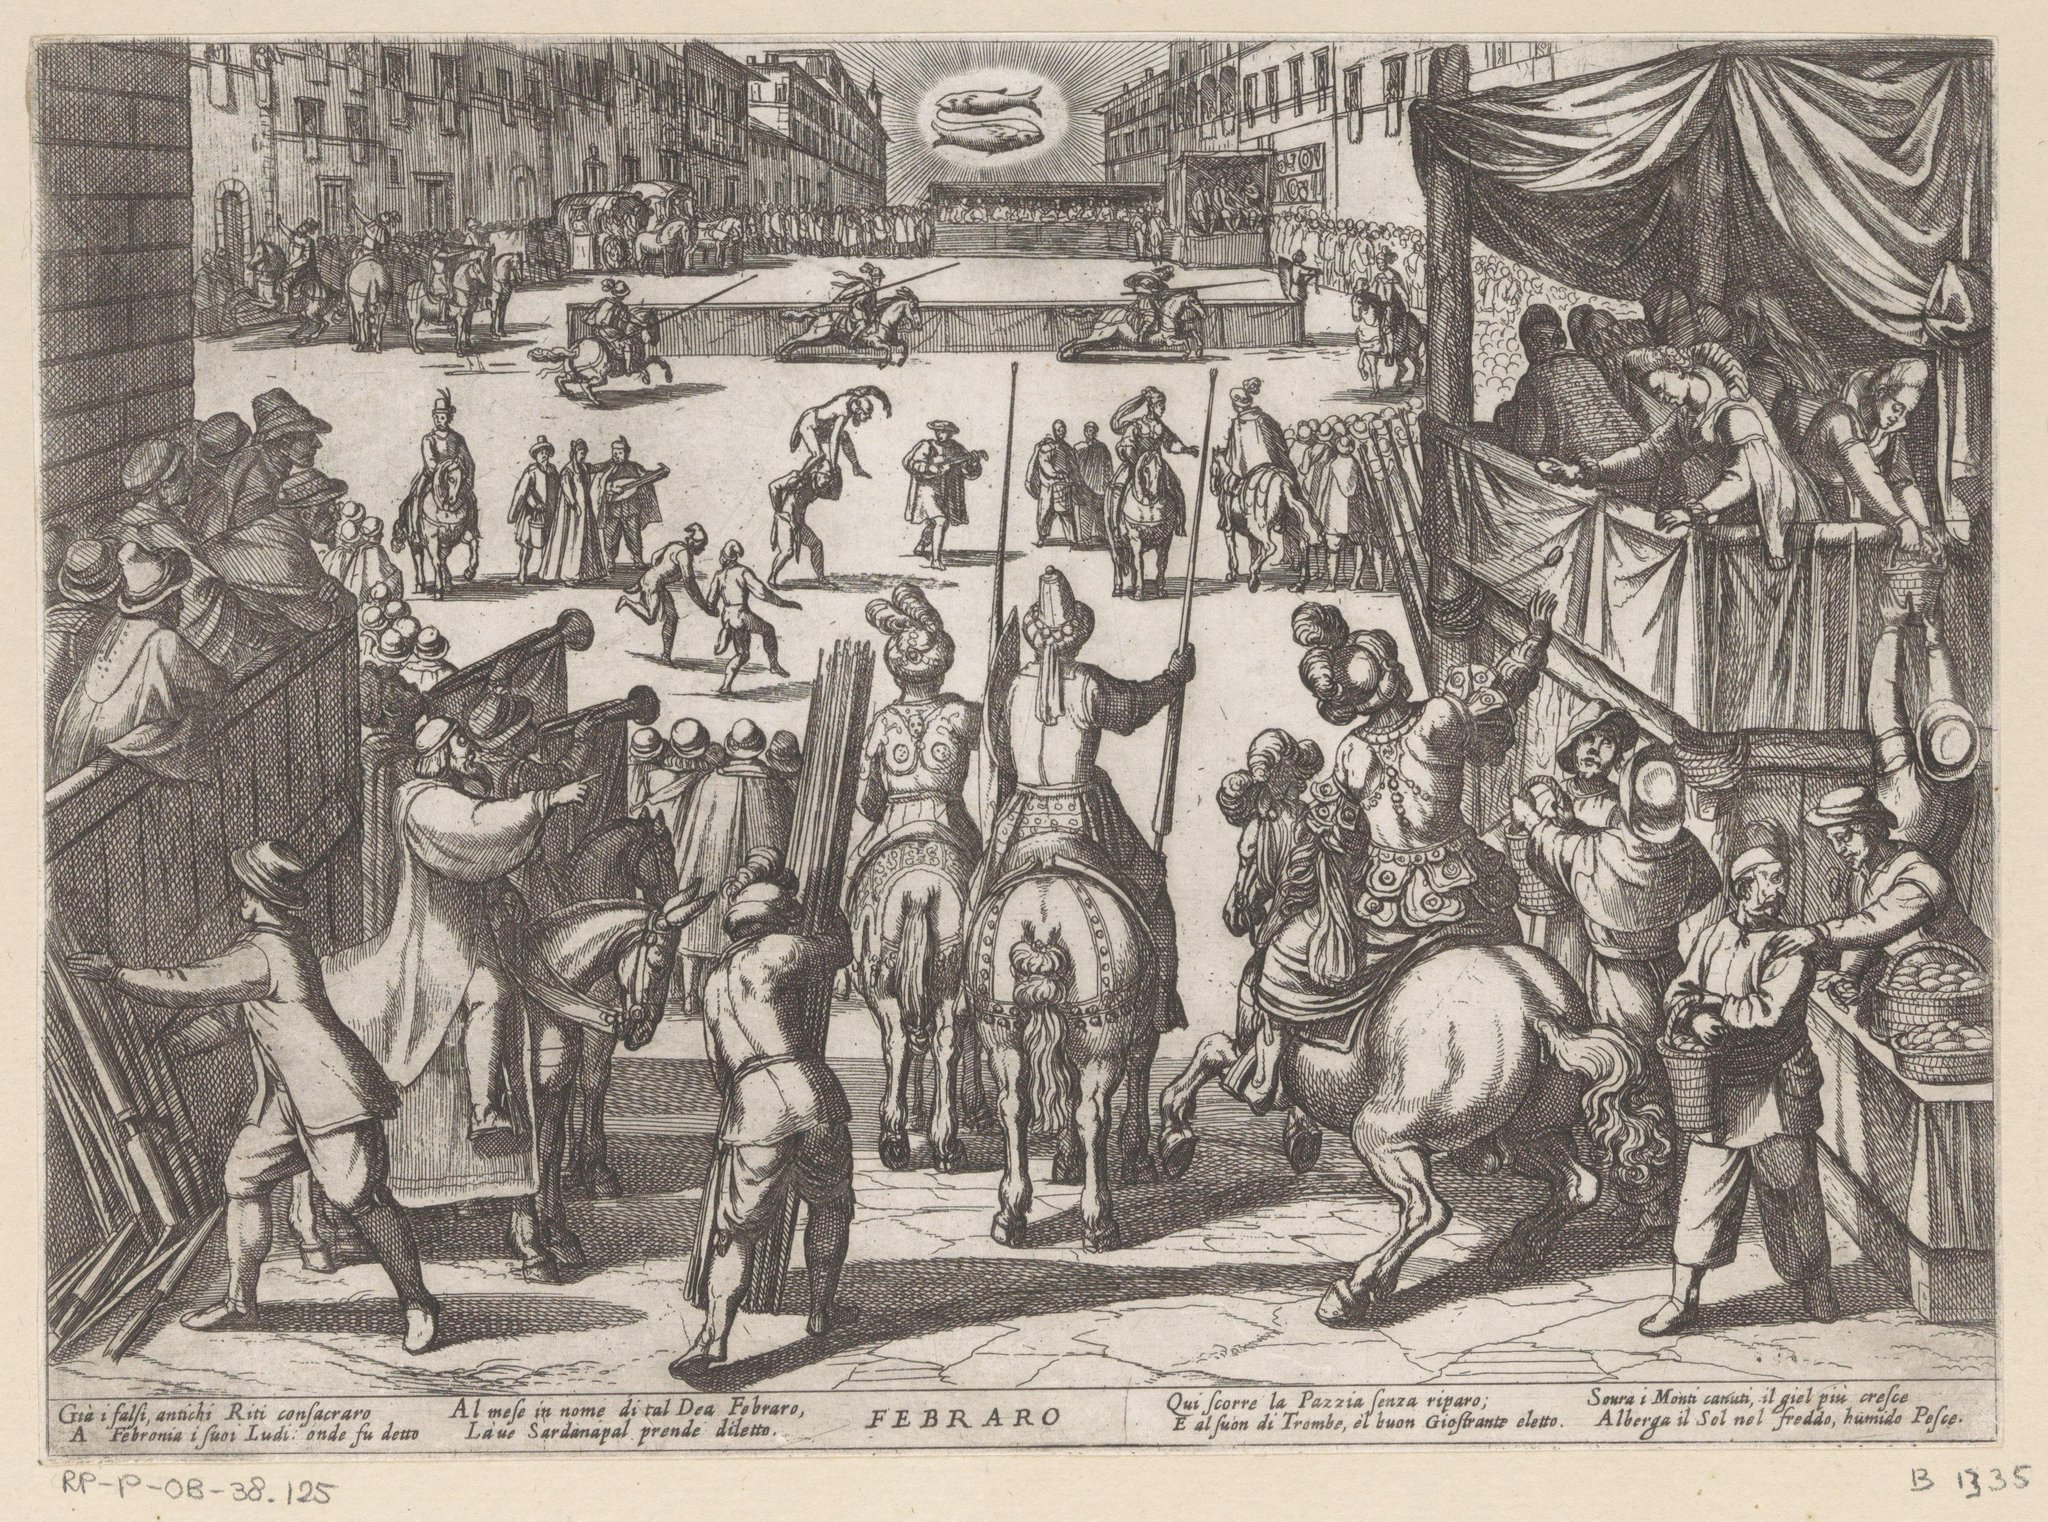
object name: print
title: Febraro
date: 1599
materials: paper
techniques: etching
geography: italy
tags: the twelve months represented by scenes showing human activities, usually in a landscape; so-called 'labours of the months', tournament, pisces (zodiacal sign of february), joust, tilt, with barrier, festivities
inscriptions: collector's mark: Lugt 240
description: Verbeelding van menselijke activiteit in de maand februari. Gezicht op een plein waar festiviteiten en een toernooi plaatsvinden. Midden boven het symbool voor het sterrenbeeld vissen. Italiaans vers en titel in ondermarge.